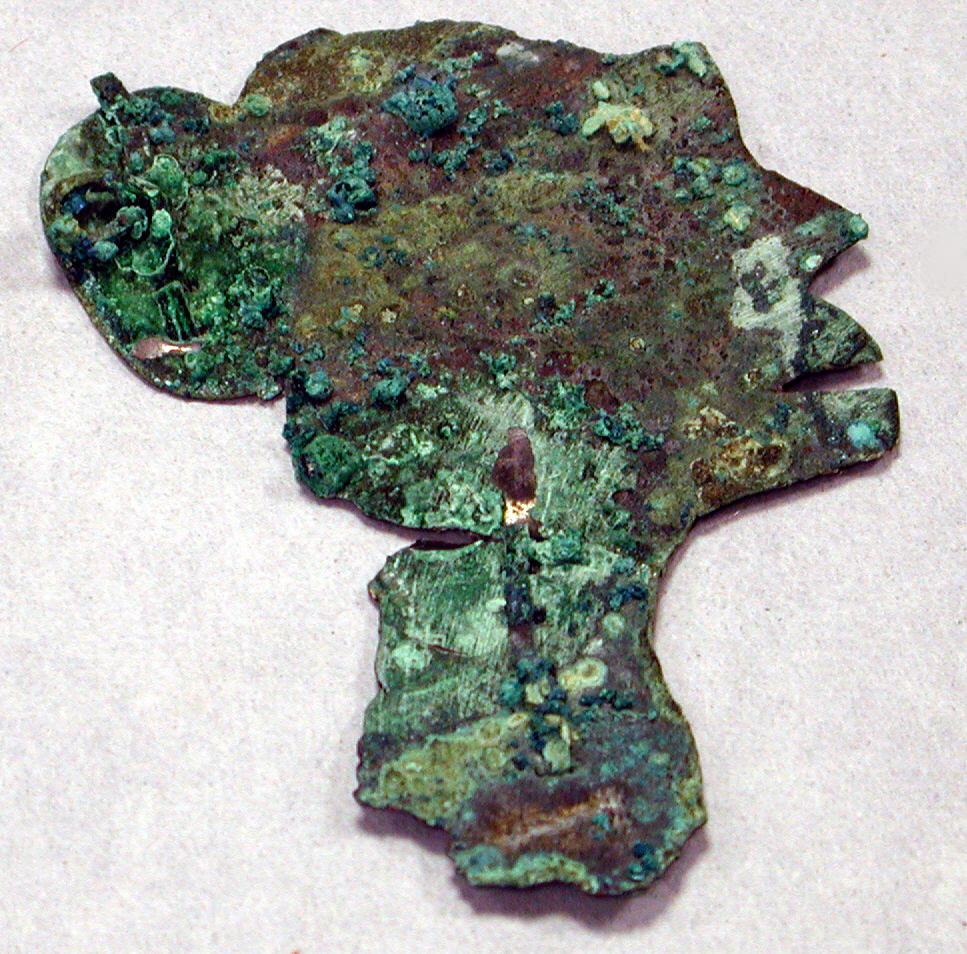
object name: ornament fragment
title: Figure Fragment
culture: moche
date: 501-700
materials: gilt copper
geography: peru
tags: faces